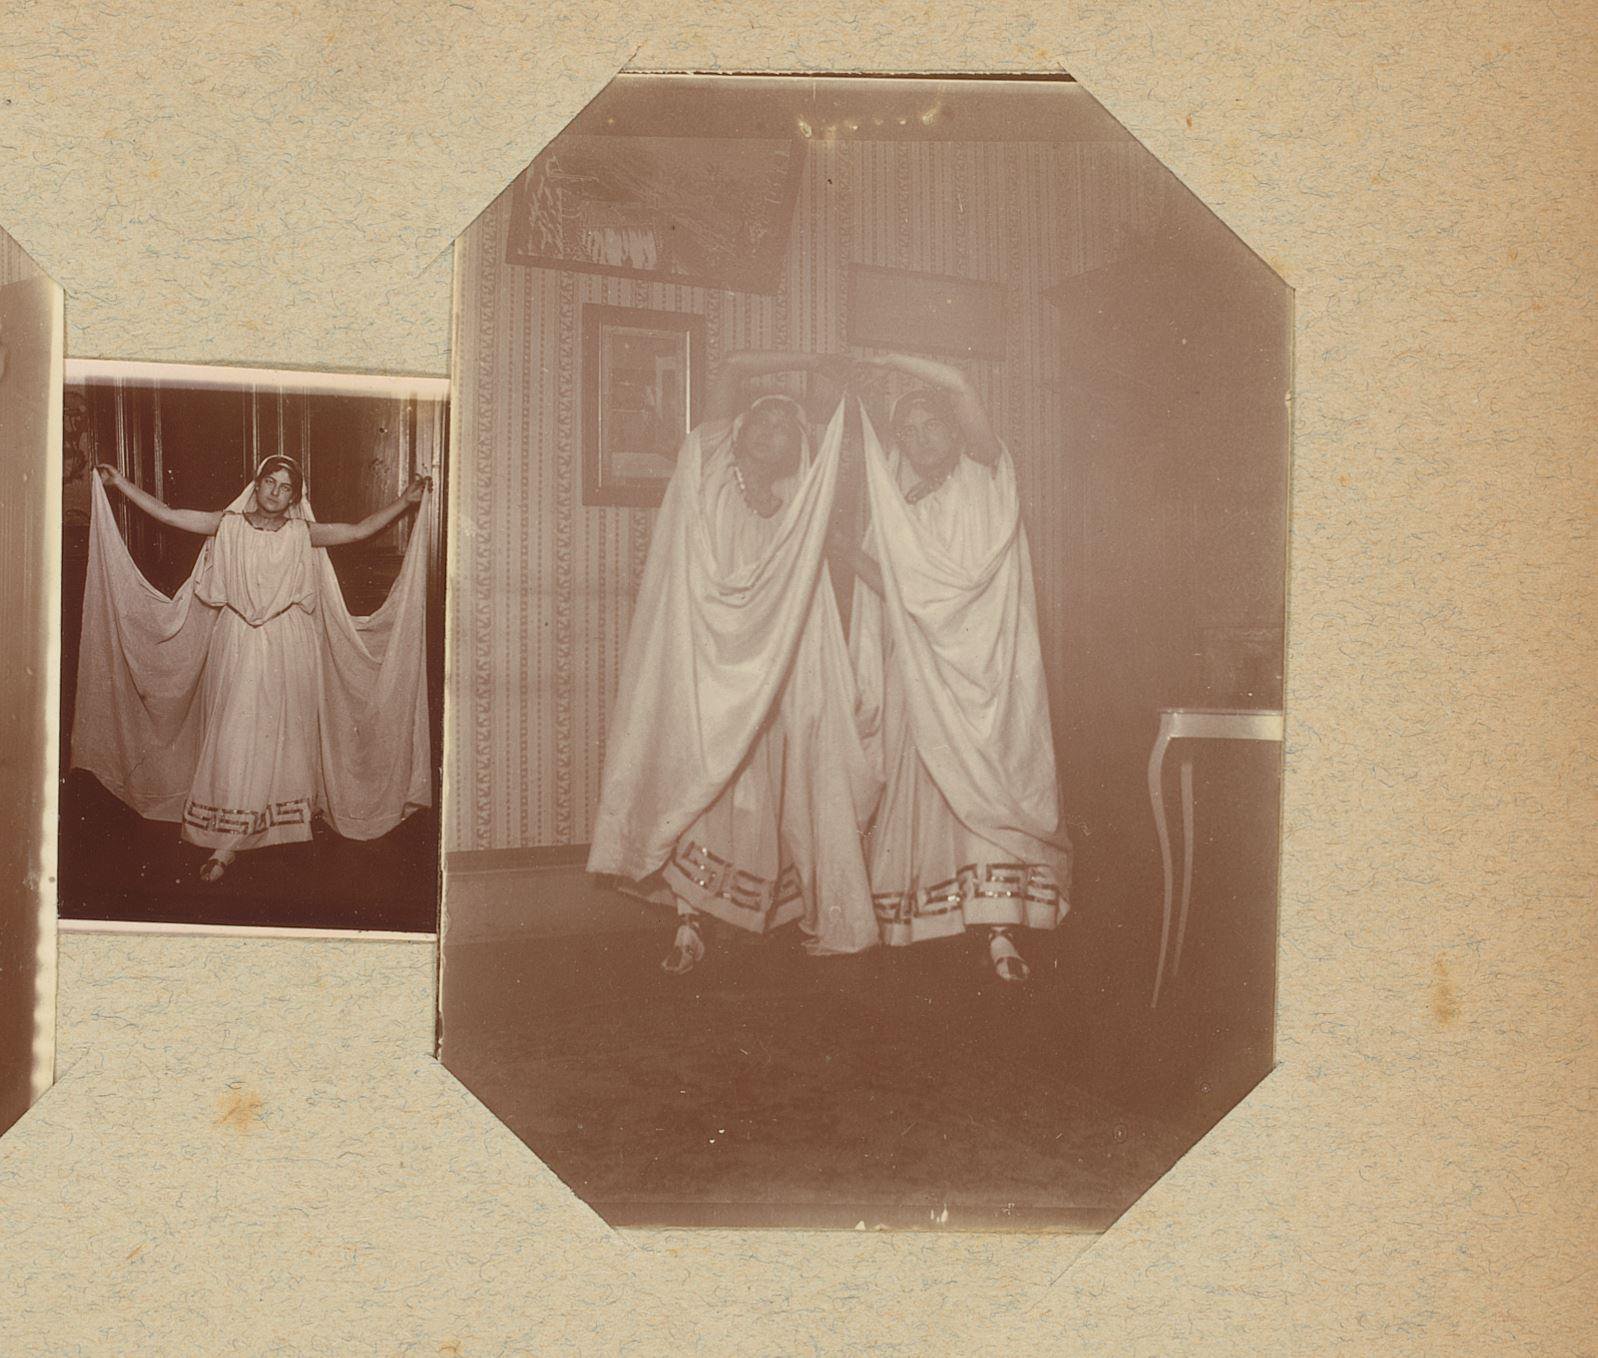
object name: photograph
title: Portret van twee vrouwen in verkleedkleding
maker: Anonymous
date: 1897-1900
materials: paper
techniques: gelatin silver print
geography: france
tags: adult woman, historical persons, historical costume, france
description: Over de foto is een ander negatief afgedrukt van een voorstelling van bomen.